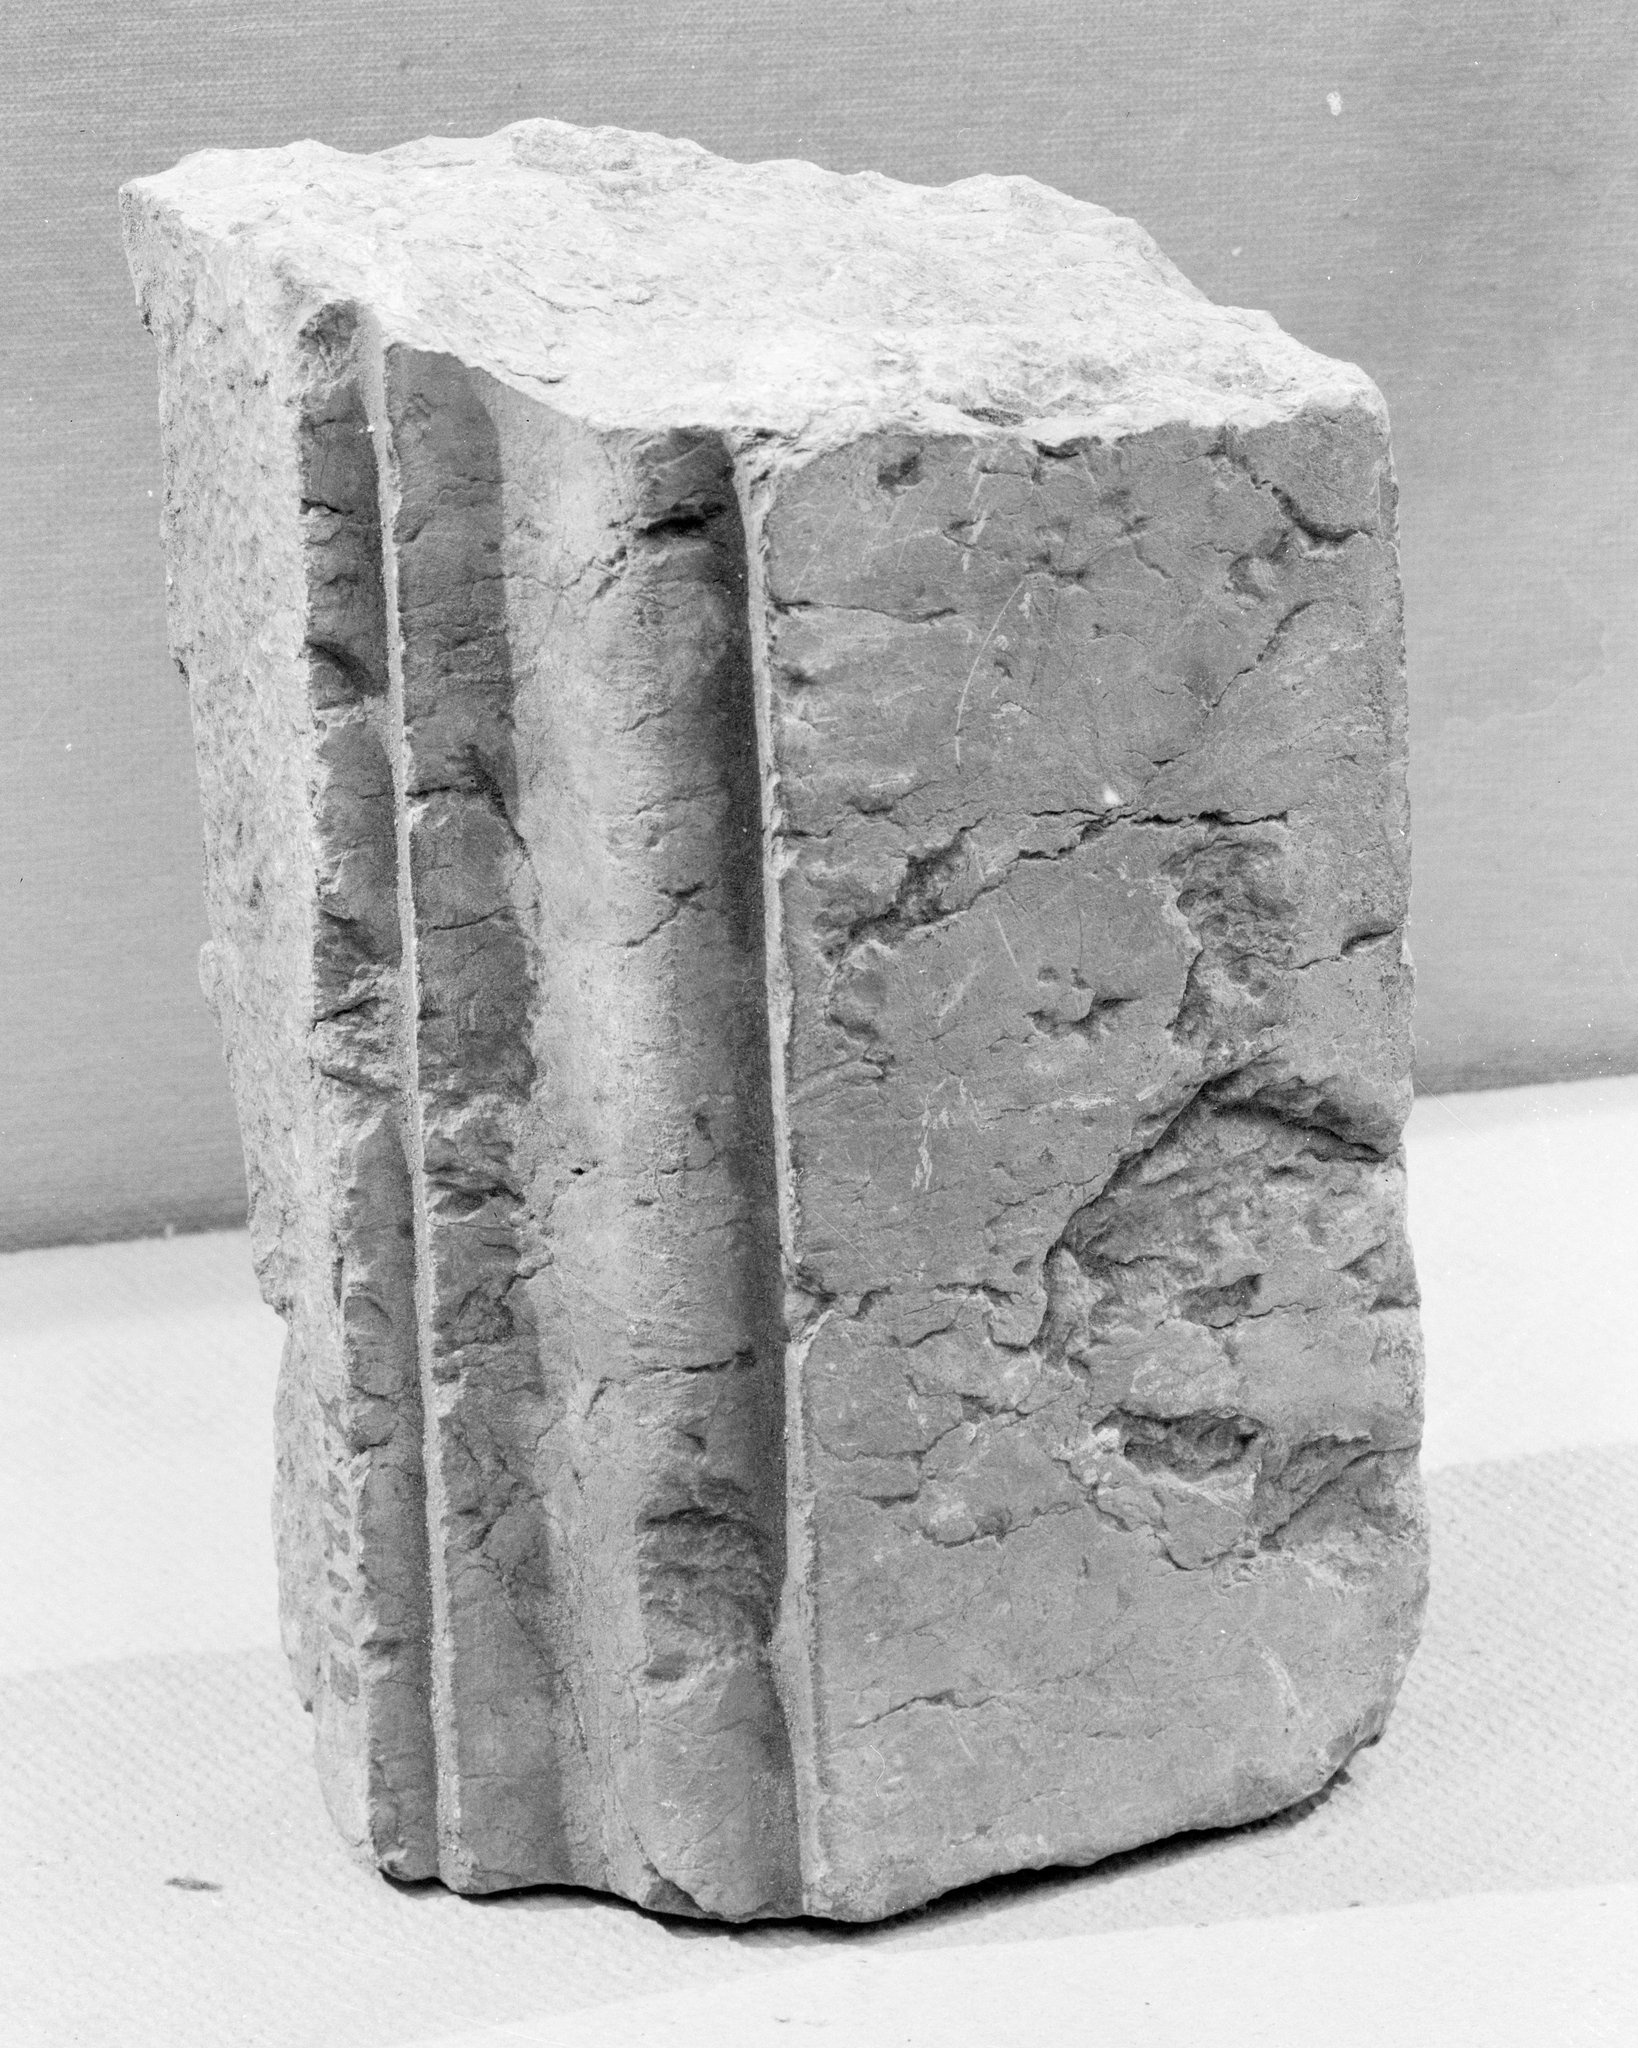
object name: block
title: Parapet Block Fragment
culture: french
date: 1130-1140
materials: stone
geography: france